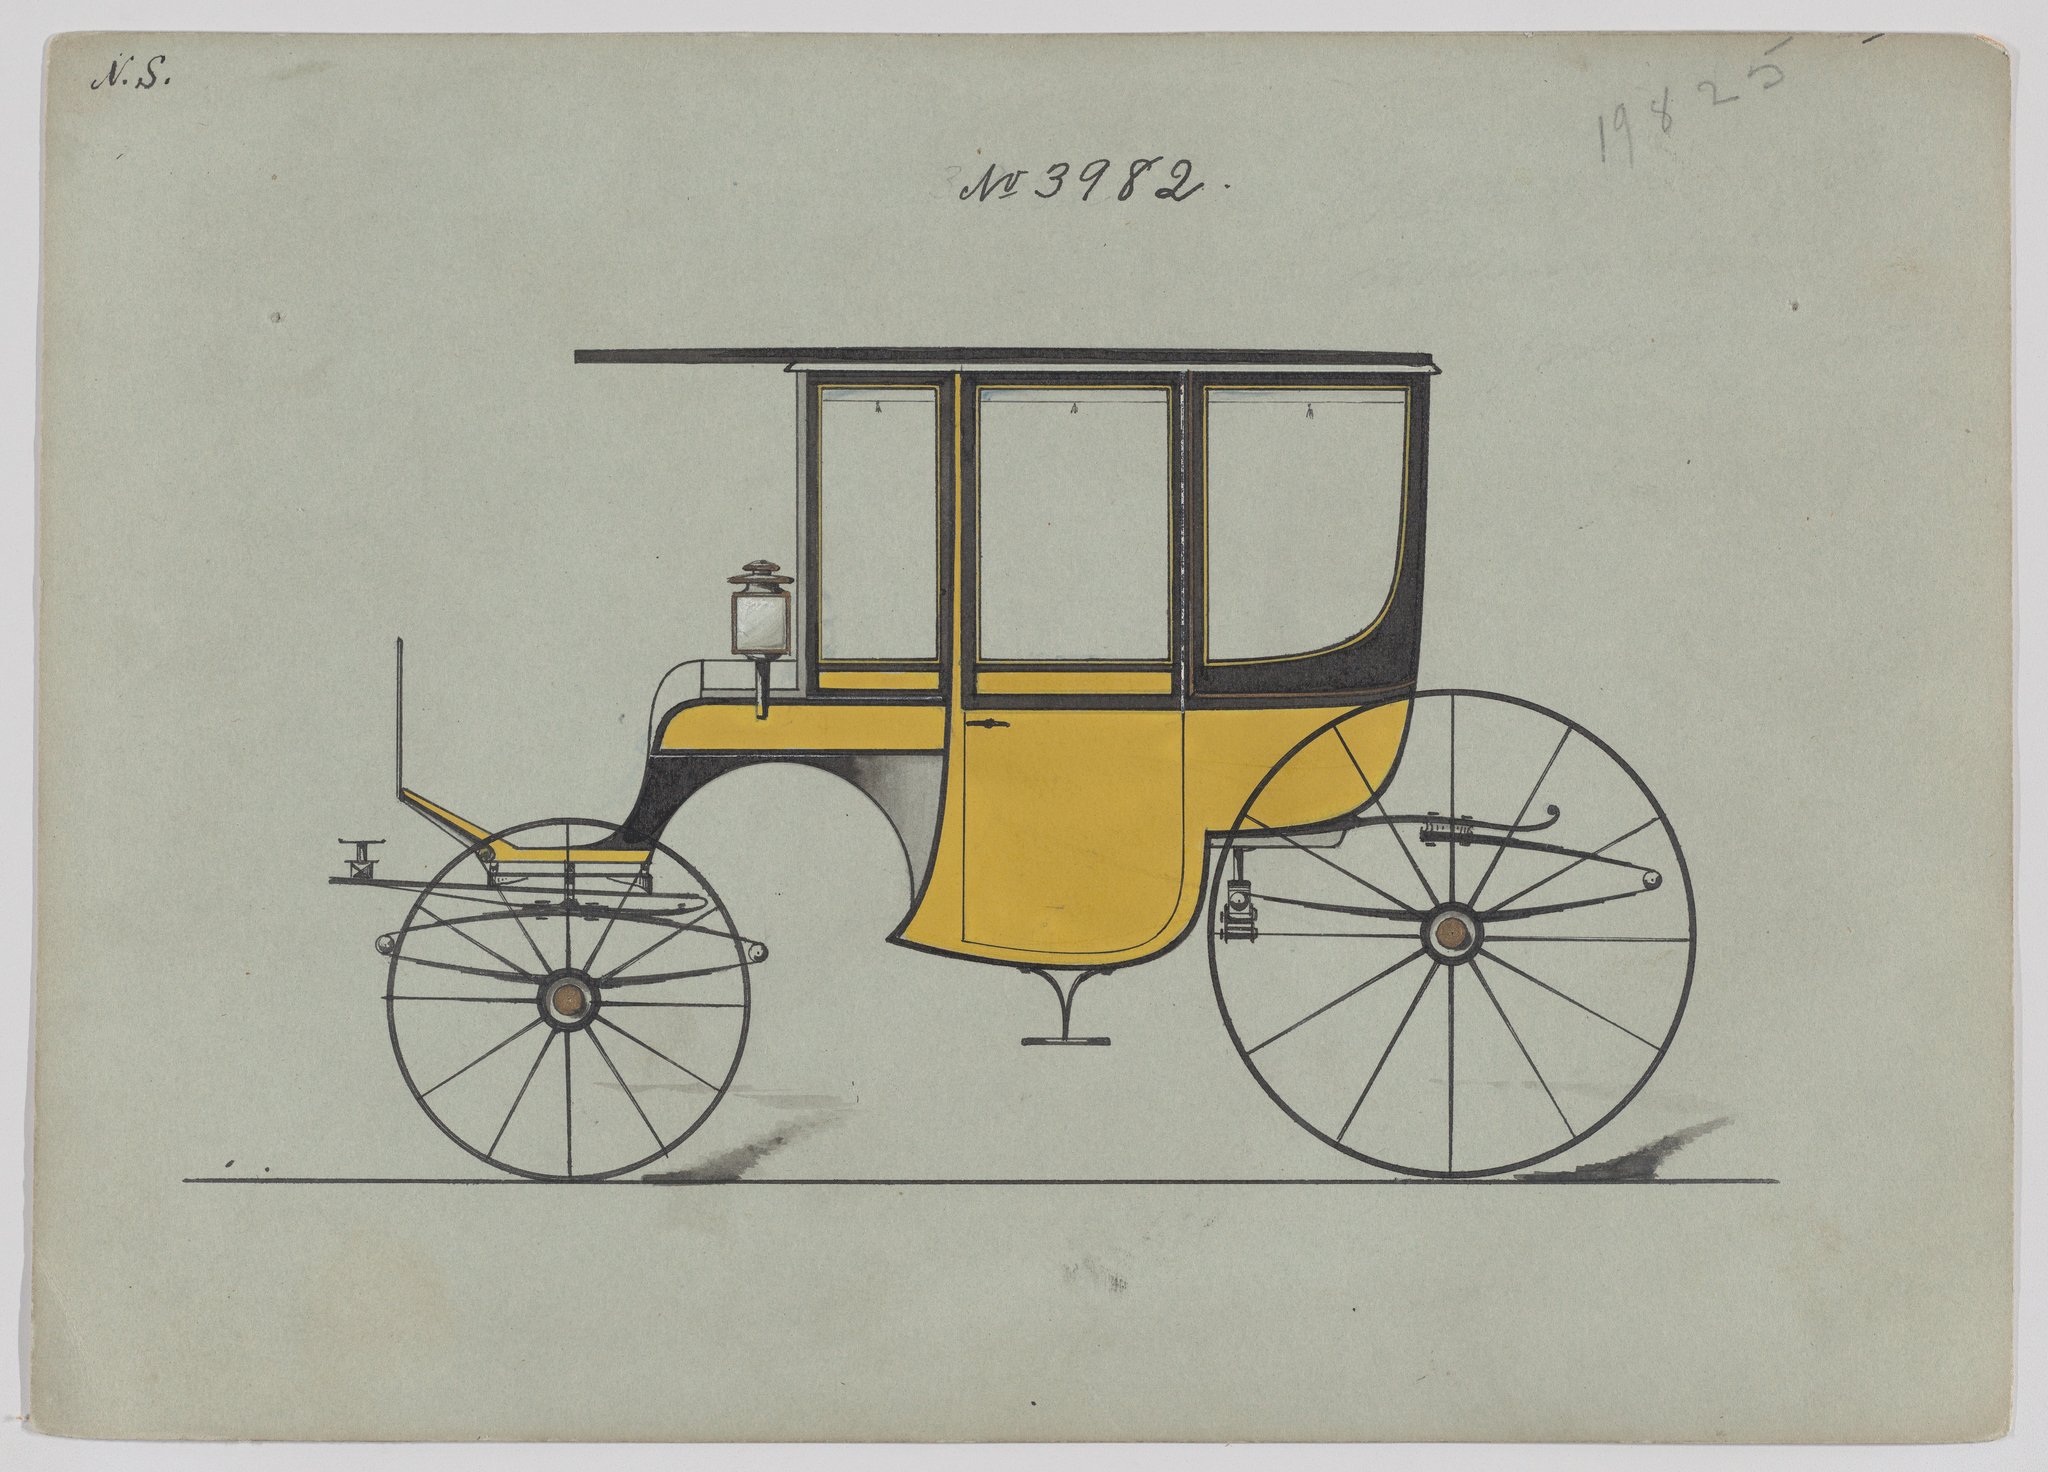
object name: drawing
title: Design for 6 seat Rockaway, no. 3982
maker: brewster & co.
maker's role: manufacturer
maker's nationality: american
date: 1886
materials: gouache, ink, watercolor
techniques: pen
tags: carriages